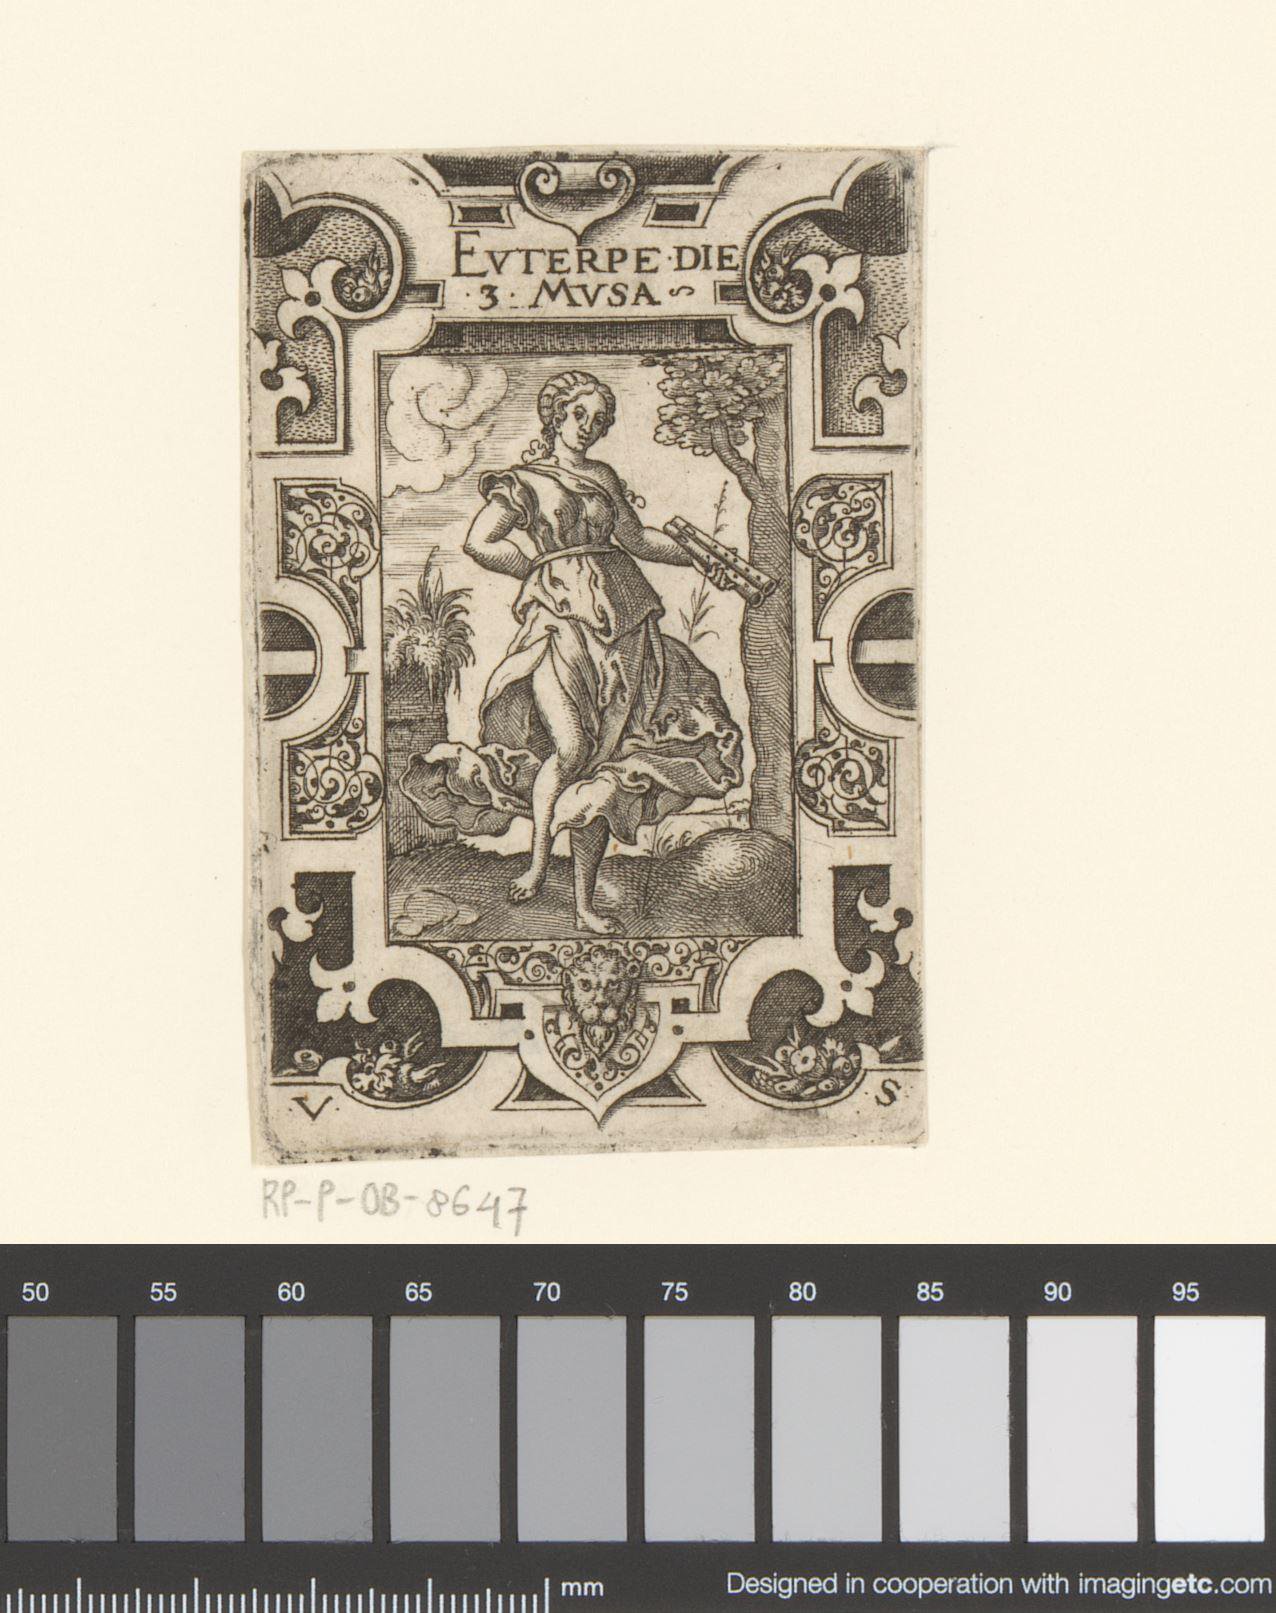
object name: print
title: Euterpe in rolwerk omlijsting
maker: virgilius solis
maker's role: draughtsman, print maker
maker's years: 1514-1562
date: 1524-1562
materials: paper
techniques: engraving, etching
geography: nuremberg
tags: euterpe (one of the muses); 'euterpe' (ripa)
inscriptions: collector's mark: Lugt 2228, number: ‘62’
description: Prent maakt deel uit van een serie bestaande uit negen prenten met de muzen.